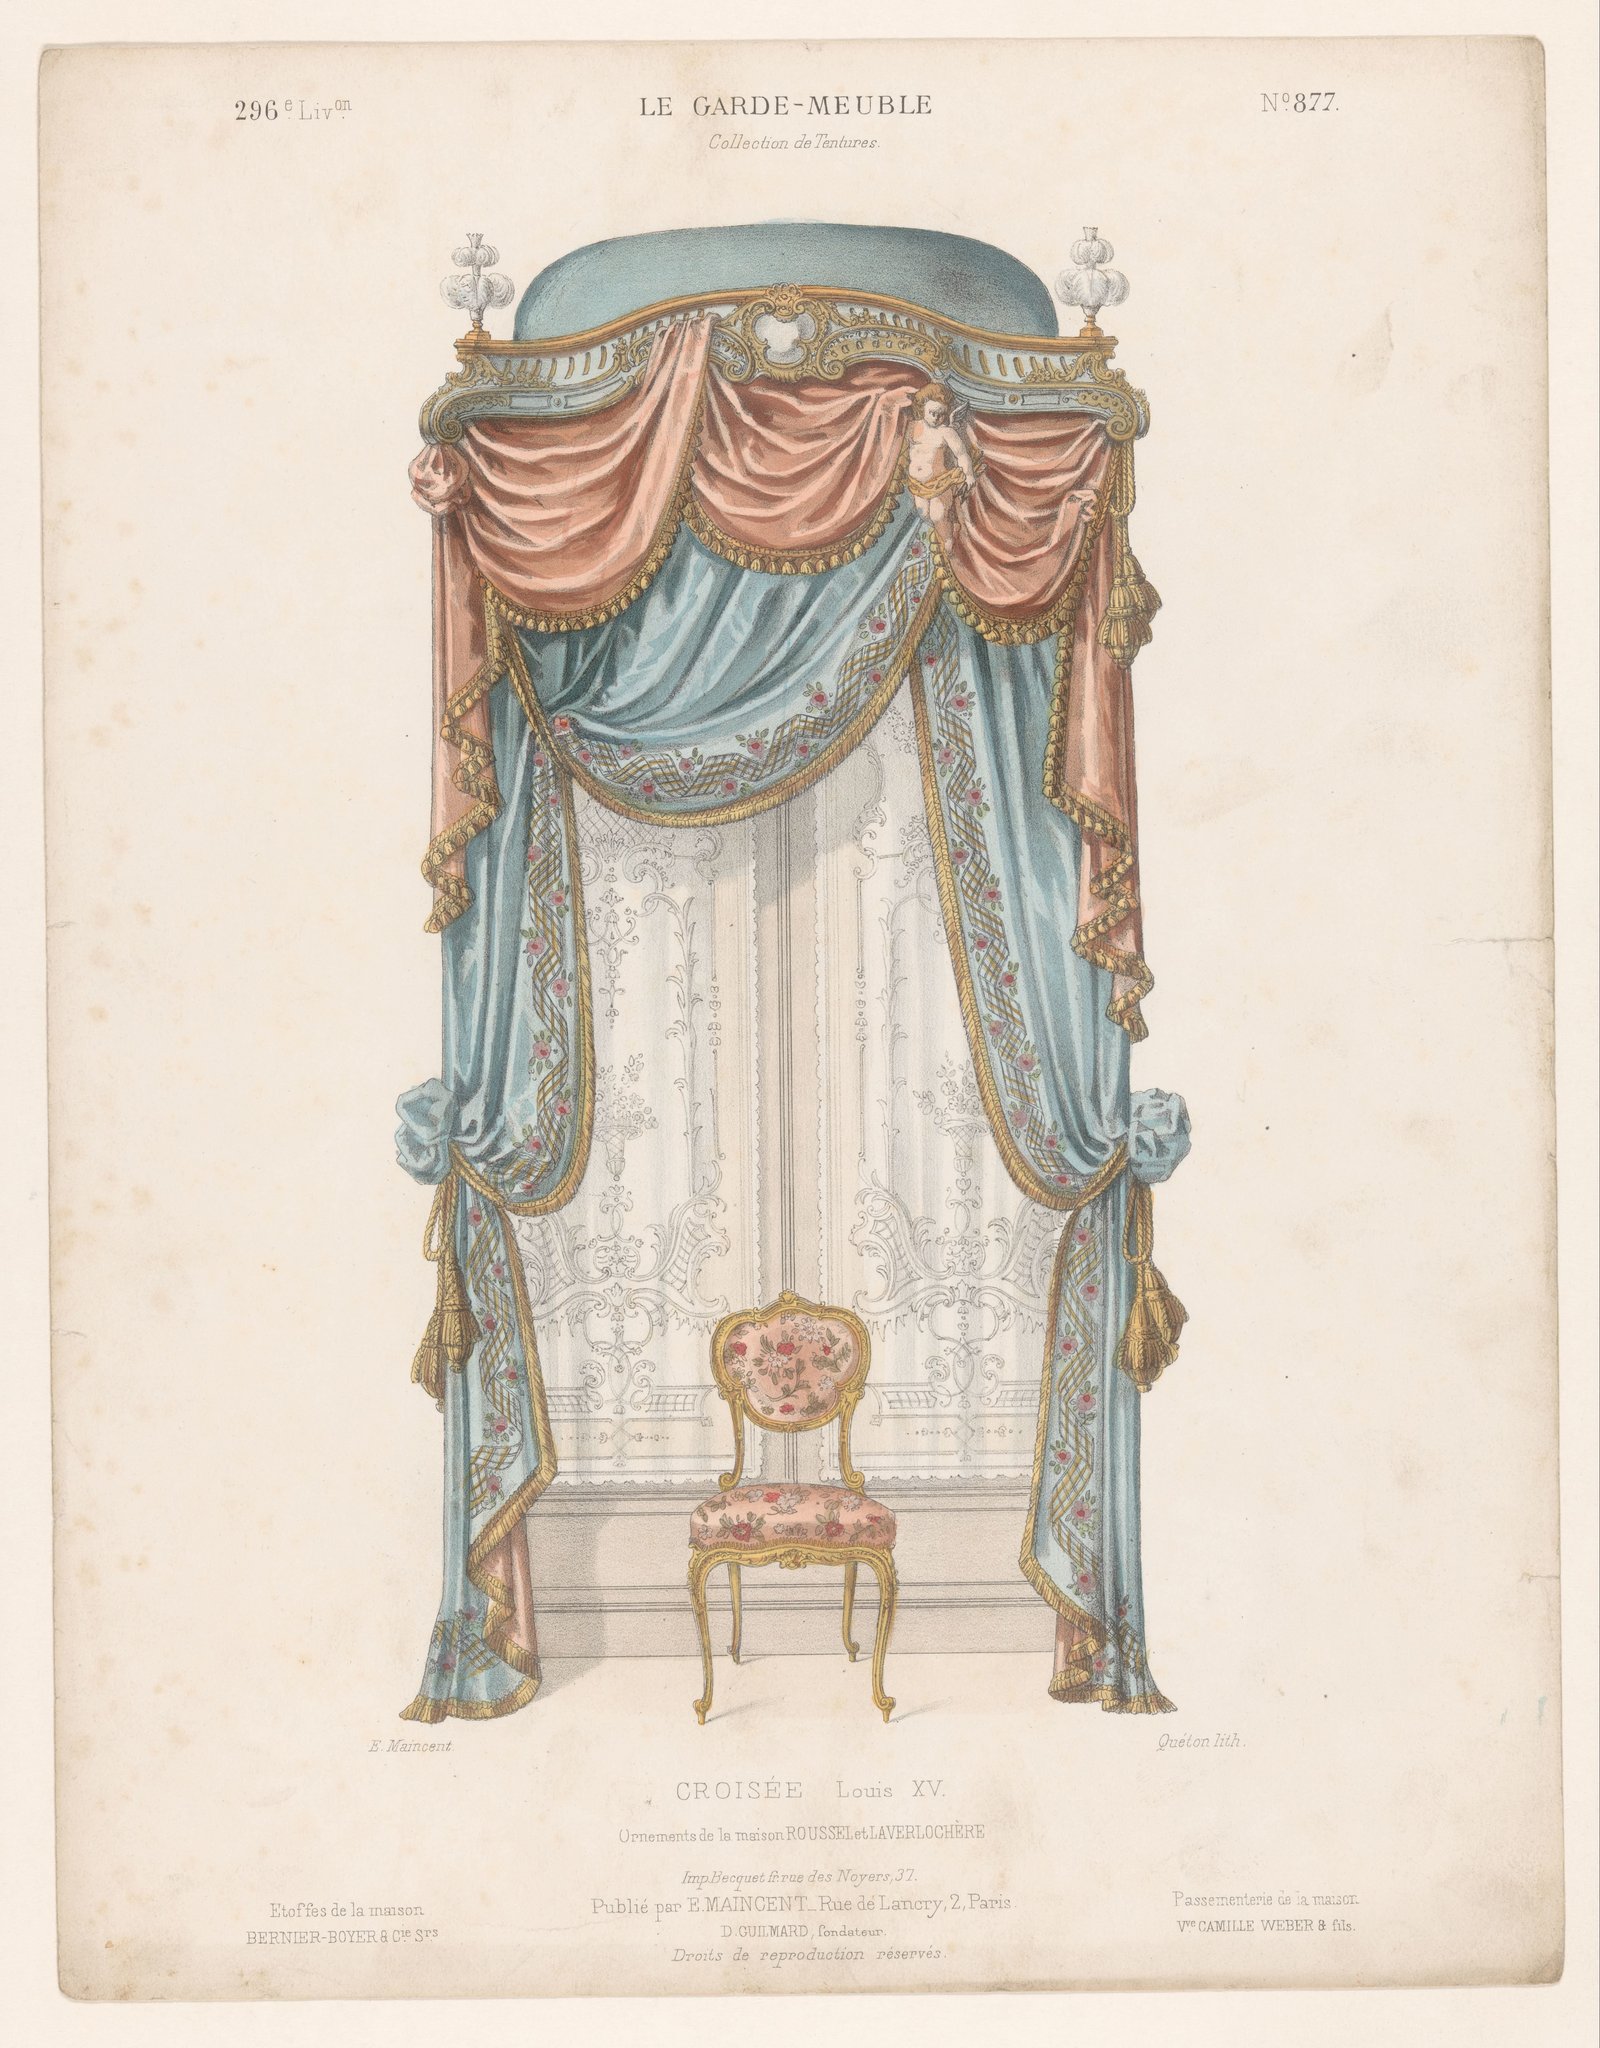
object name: print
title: Venster met gordijnen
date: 1885-1895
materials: paper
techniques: hand coloring, lithograph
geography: paris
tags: window, hangings and drapery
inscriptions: : ‘Droits de reproduction réservés.’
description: Kruisvenster met gedrapeerde gordijnen in Lodewijk XV-stijl. Prent uit 296e Livraison.